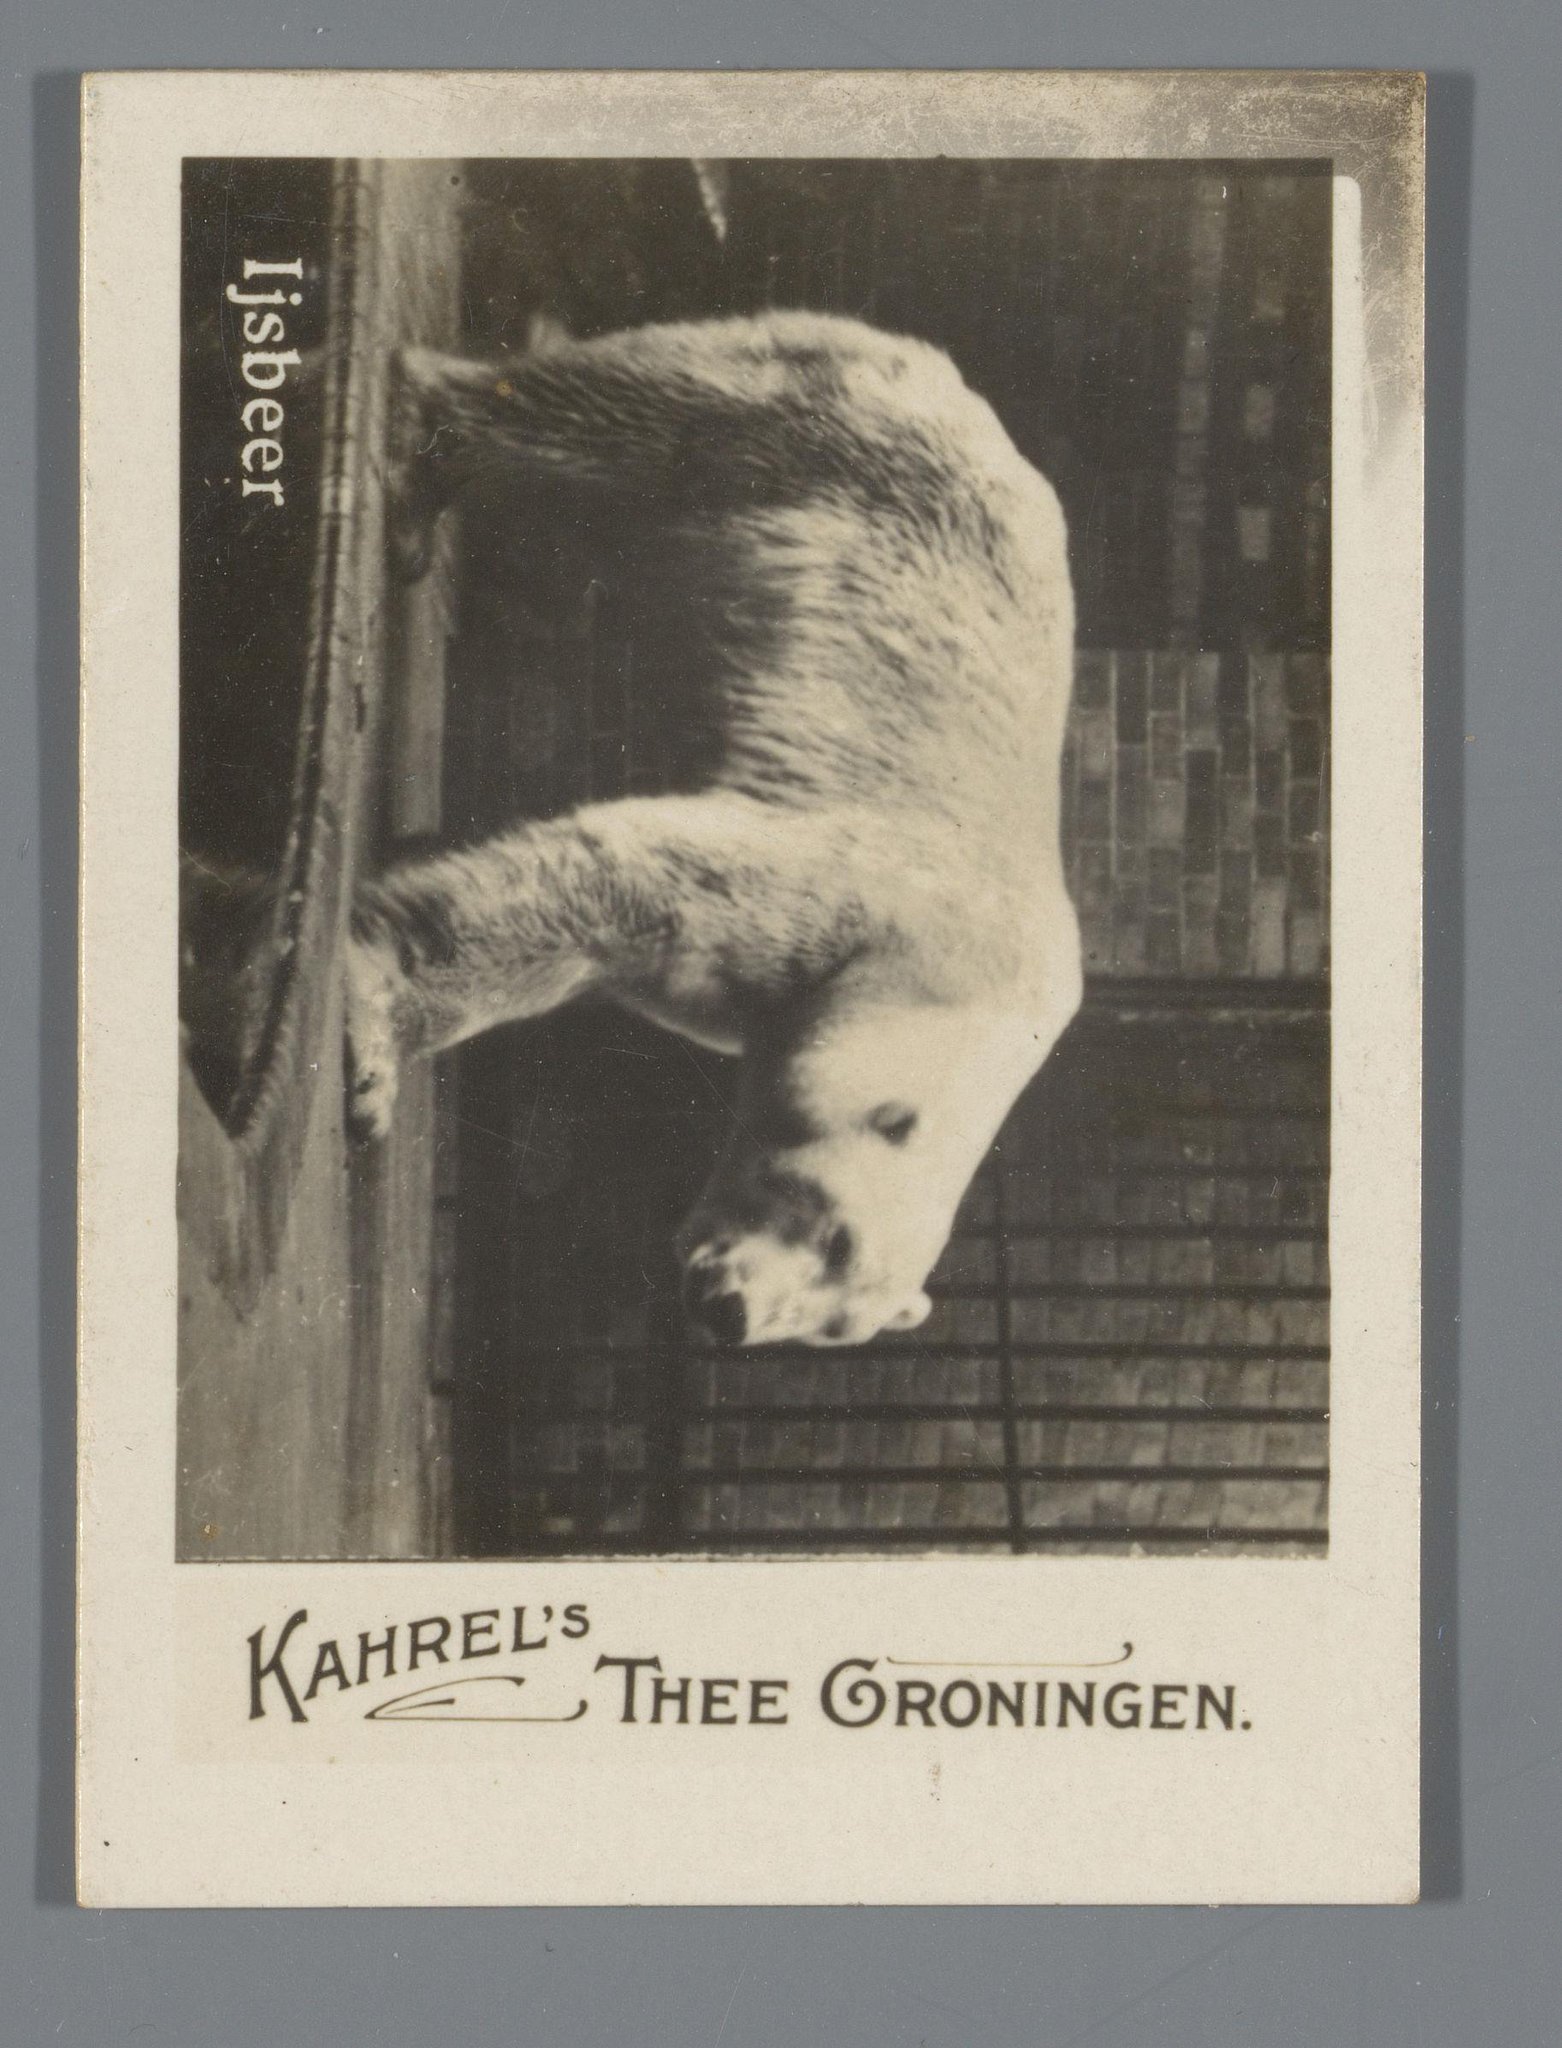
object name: photograph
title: Ijsbeer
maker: Anonymous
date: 1895-1910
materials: paper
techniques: gelatin silver print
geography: groningen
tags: beasts of prey, predatory animals: polar bear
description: Dergelijke foto's stonden bekend als 'zwartjes'. Men verkreeg ze bij aanschaf van bepaalde merken thee, cacao, sigaretten, beschuit, etc. om te verzamelen. Er waren speciaal voor de 'zwartjes' verzamelalbums in omloop.